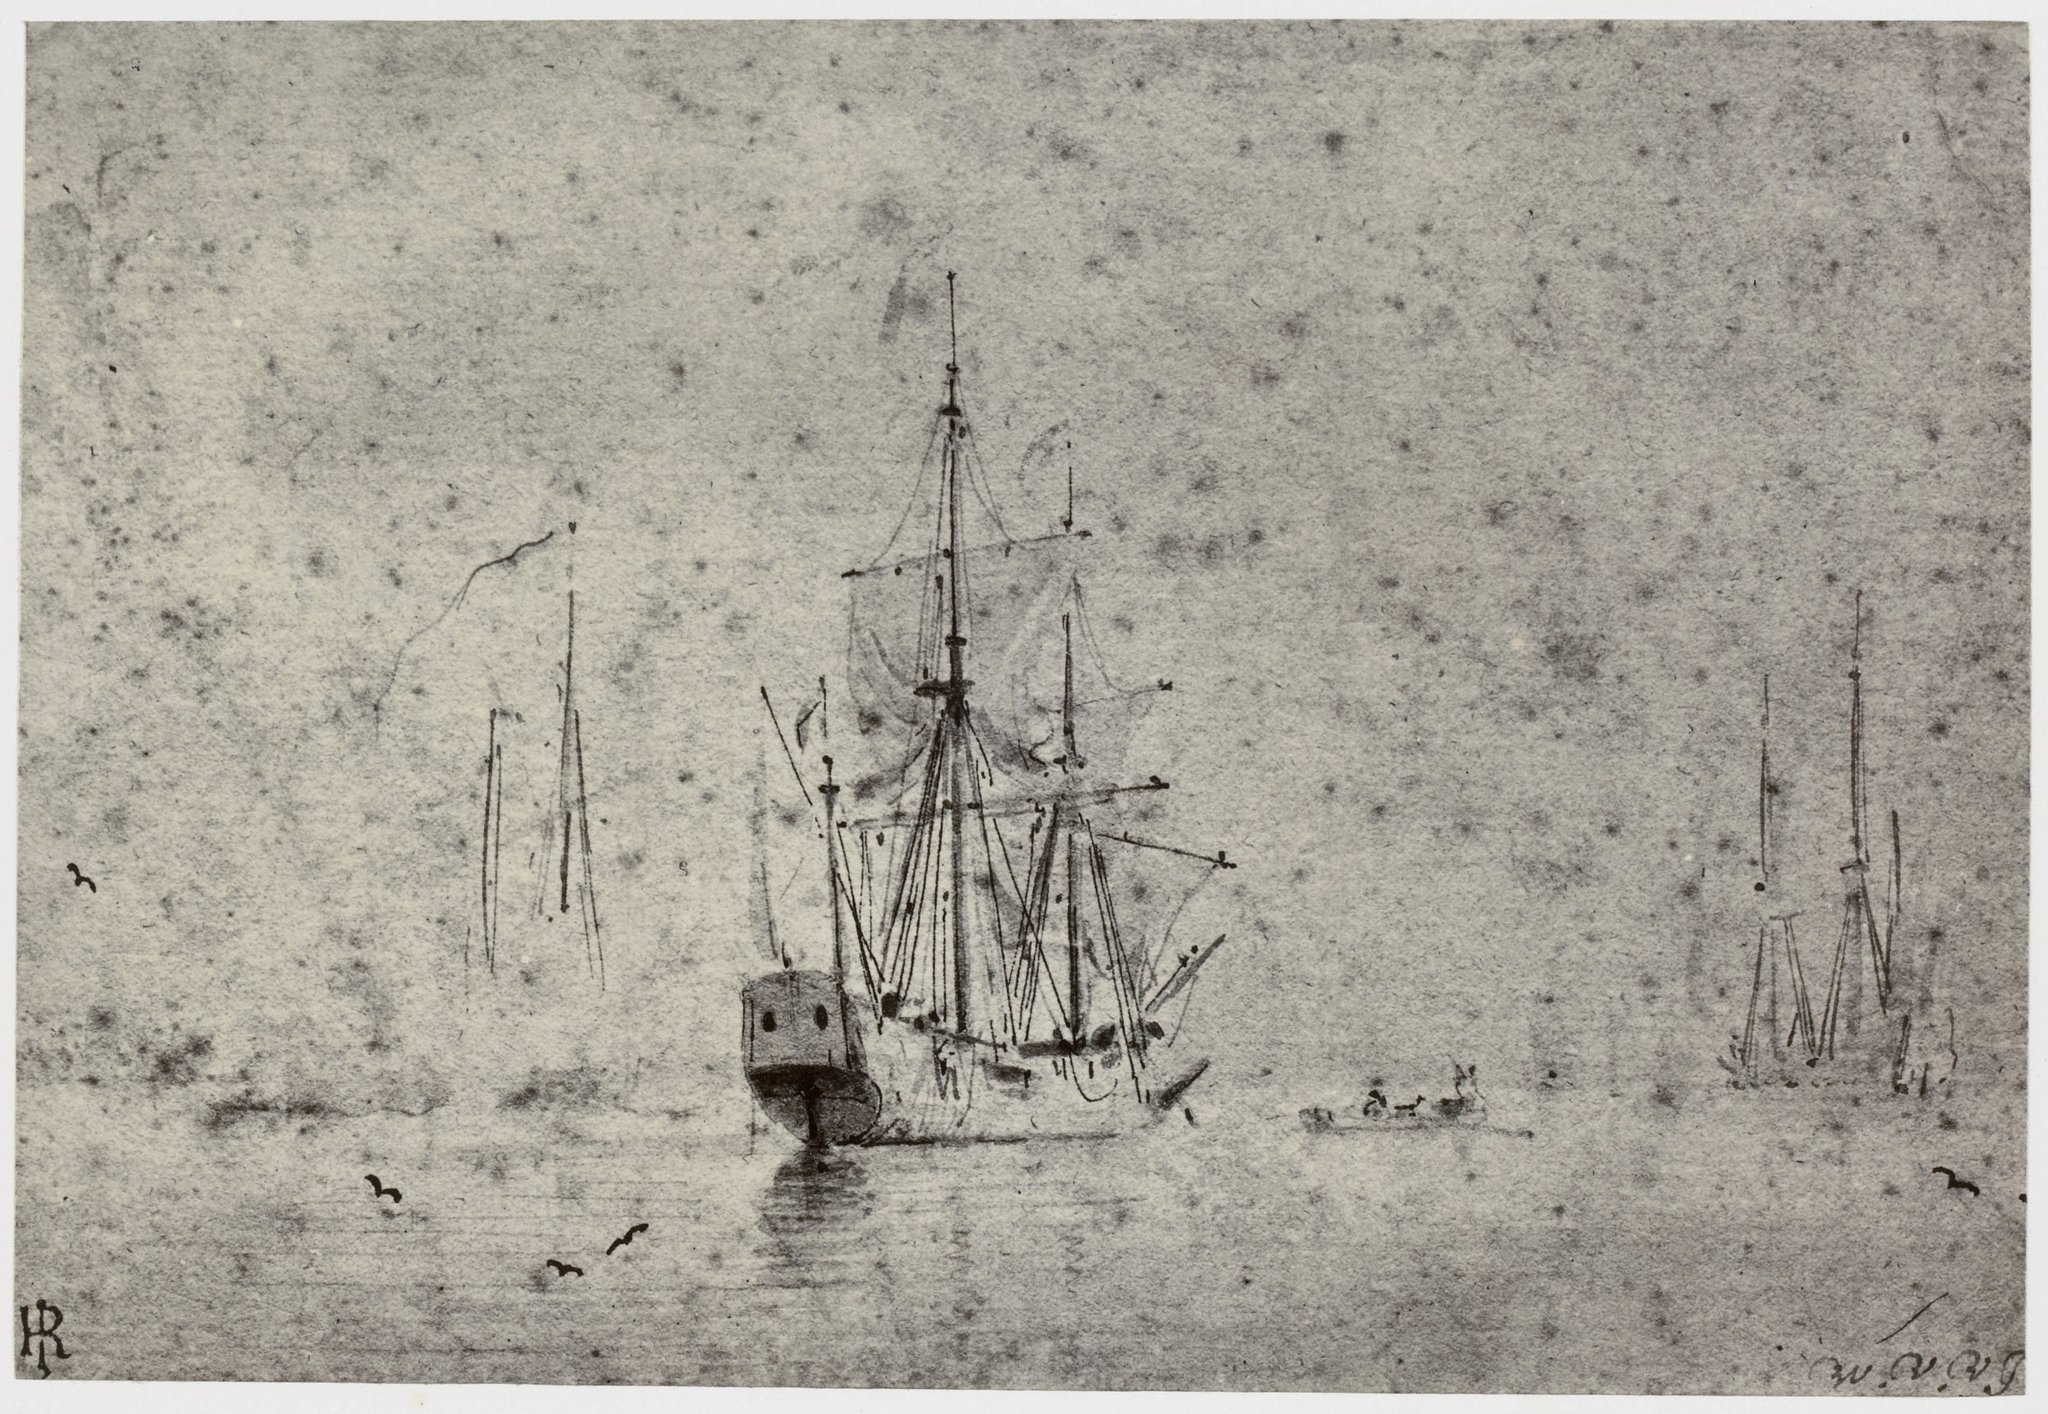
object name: photograph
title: Willem van der Velde, Shipping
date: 1855-1858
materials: cardboard, paper, photographic support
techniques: albumen print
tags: drawing, sketch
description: Fotoreproductie van tekening in 'The Reveley Collection of Drawings at Brynygwin', afb. 39.